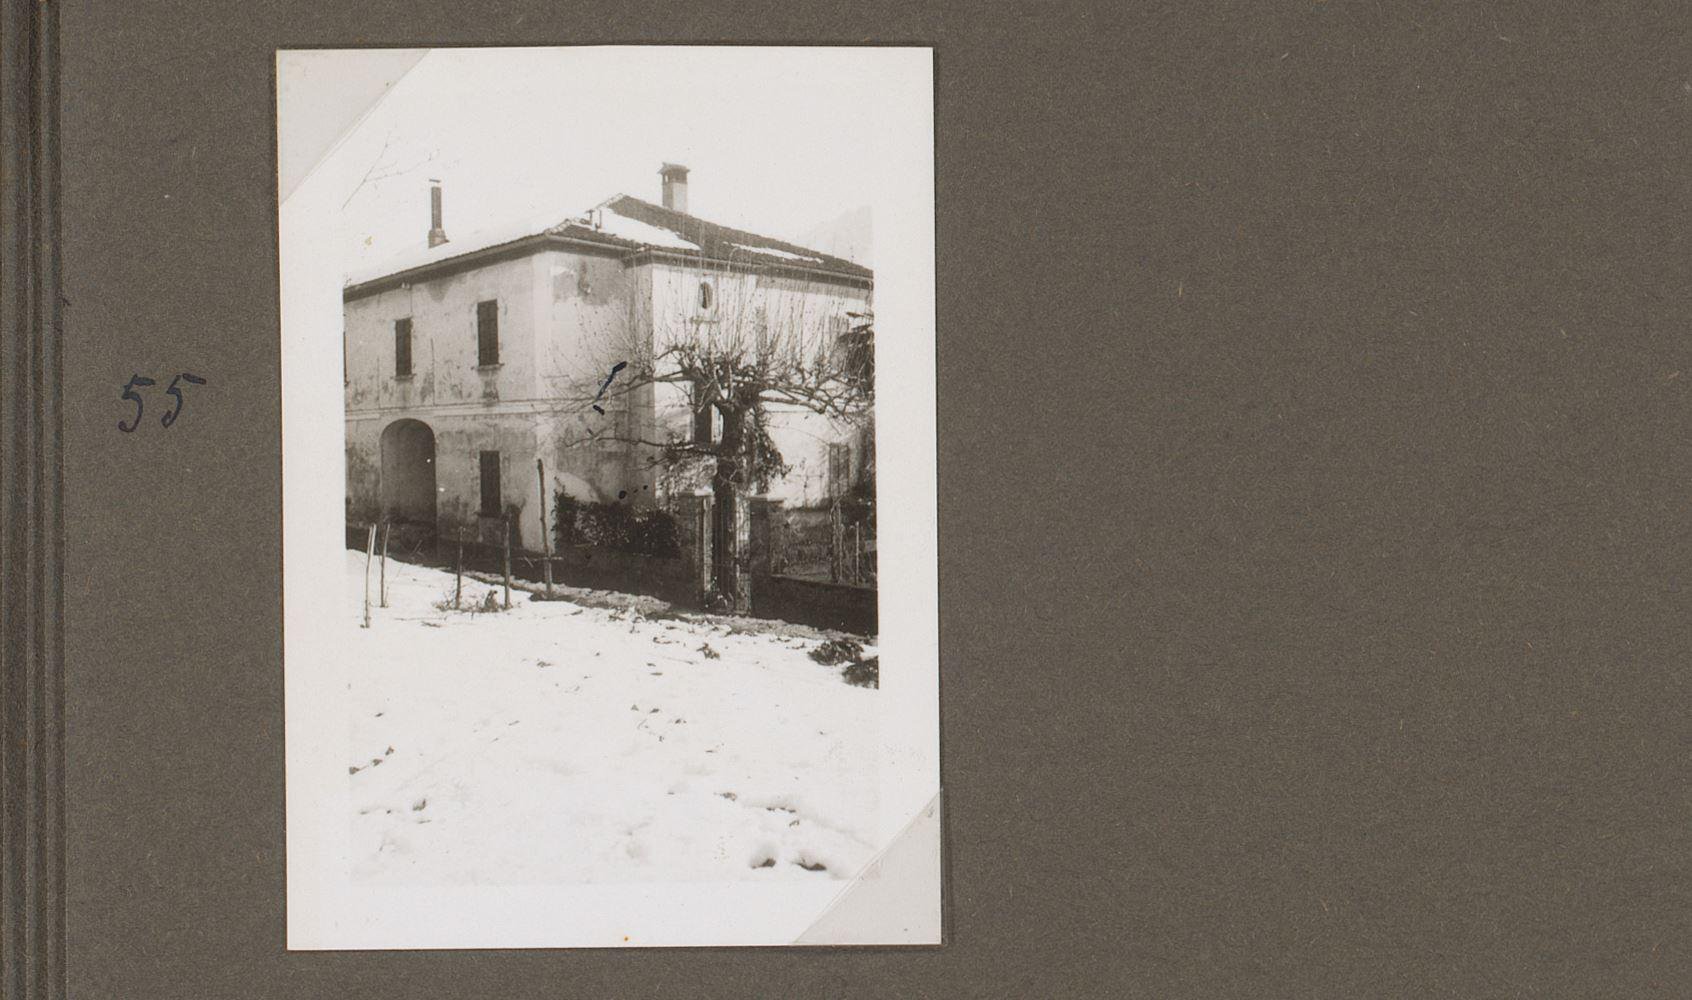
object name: album leaf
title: Luggagia. Huis van Pfarrer N. Bolt, schrijver van Svizzero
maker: Anonymous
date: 1934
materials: photographic support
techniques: gelatin silver print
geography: luggagia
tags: snow, exterior ~ representation of a building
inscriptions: number: ‘55’